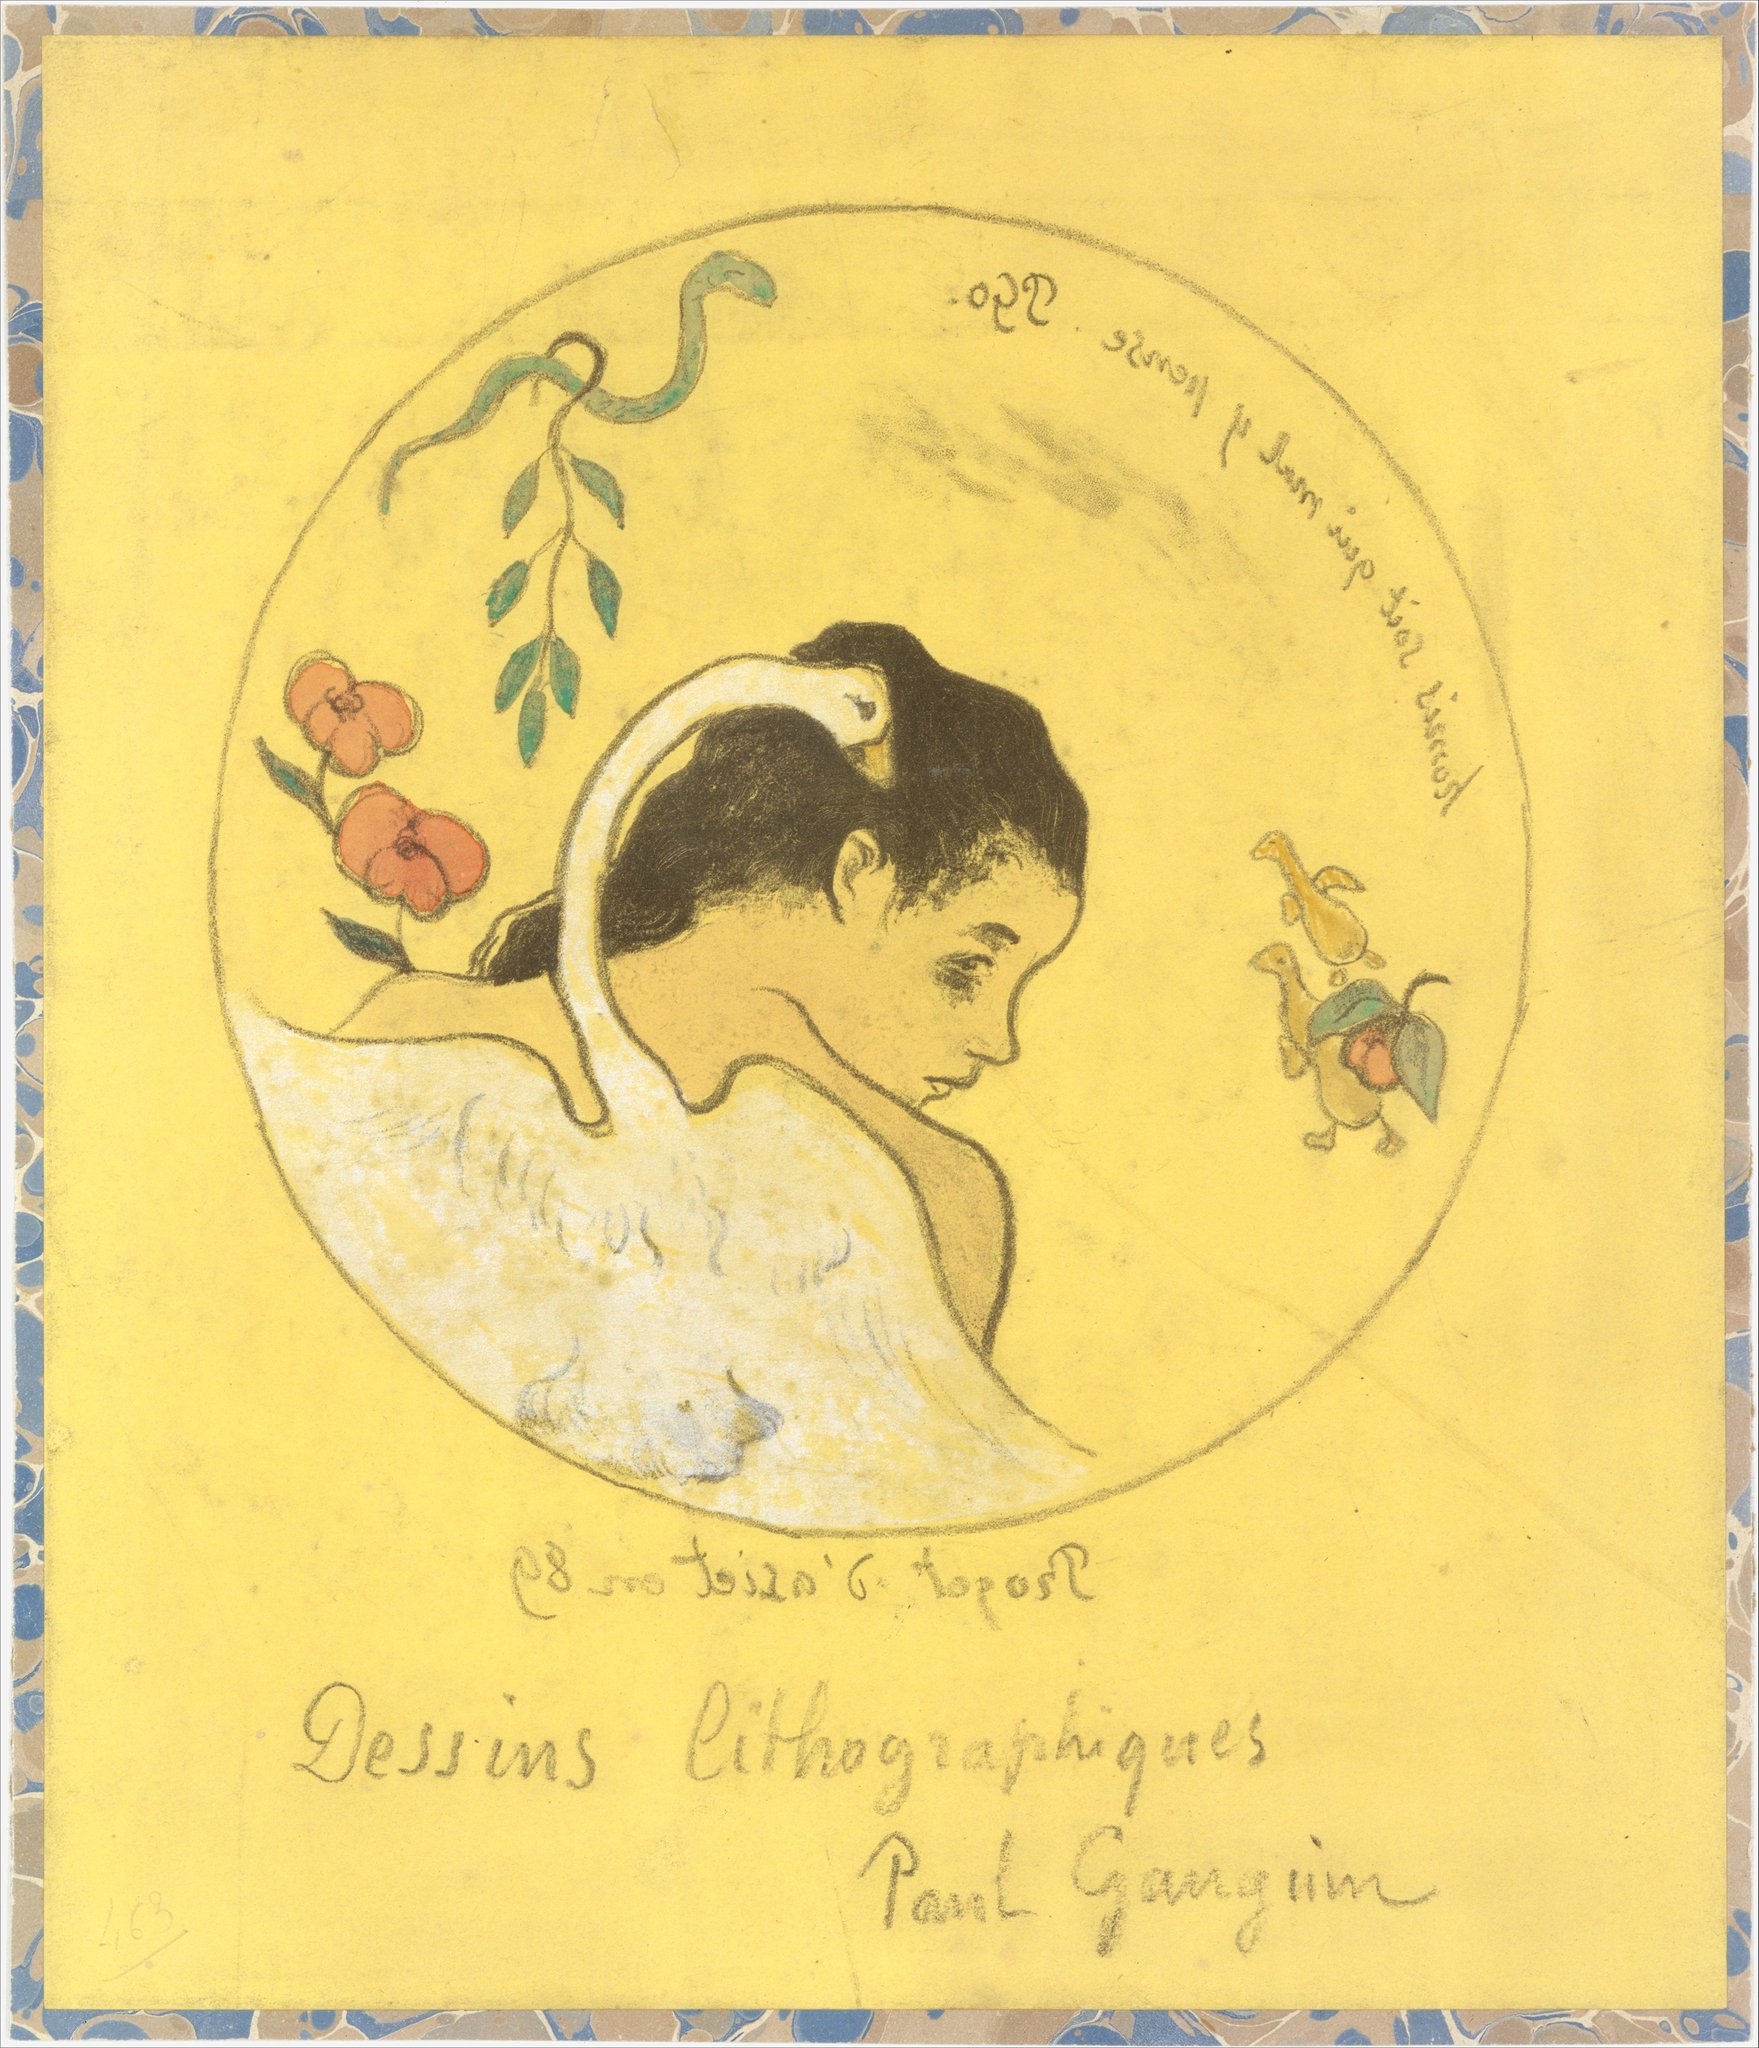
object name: print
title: ("Leda") Design for a Plate: Shame on Those Who Evil Think (Honi Soit Qui Mal y Pense) ; cover illustration for the "Volpini Suite" entitled Lithographic Drawings (Dessins lithographiques)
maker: paul gauguin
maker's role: artist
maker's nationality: french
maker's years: 1848-1903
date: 1889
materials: gouache, watercolor, paper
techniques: marbling, lithography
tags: profiles,women,flowers,leaves